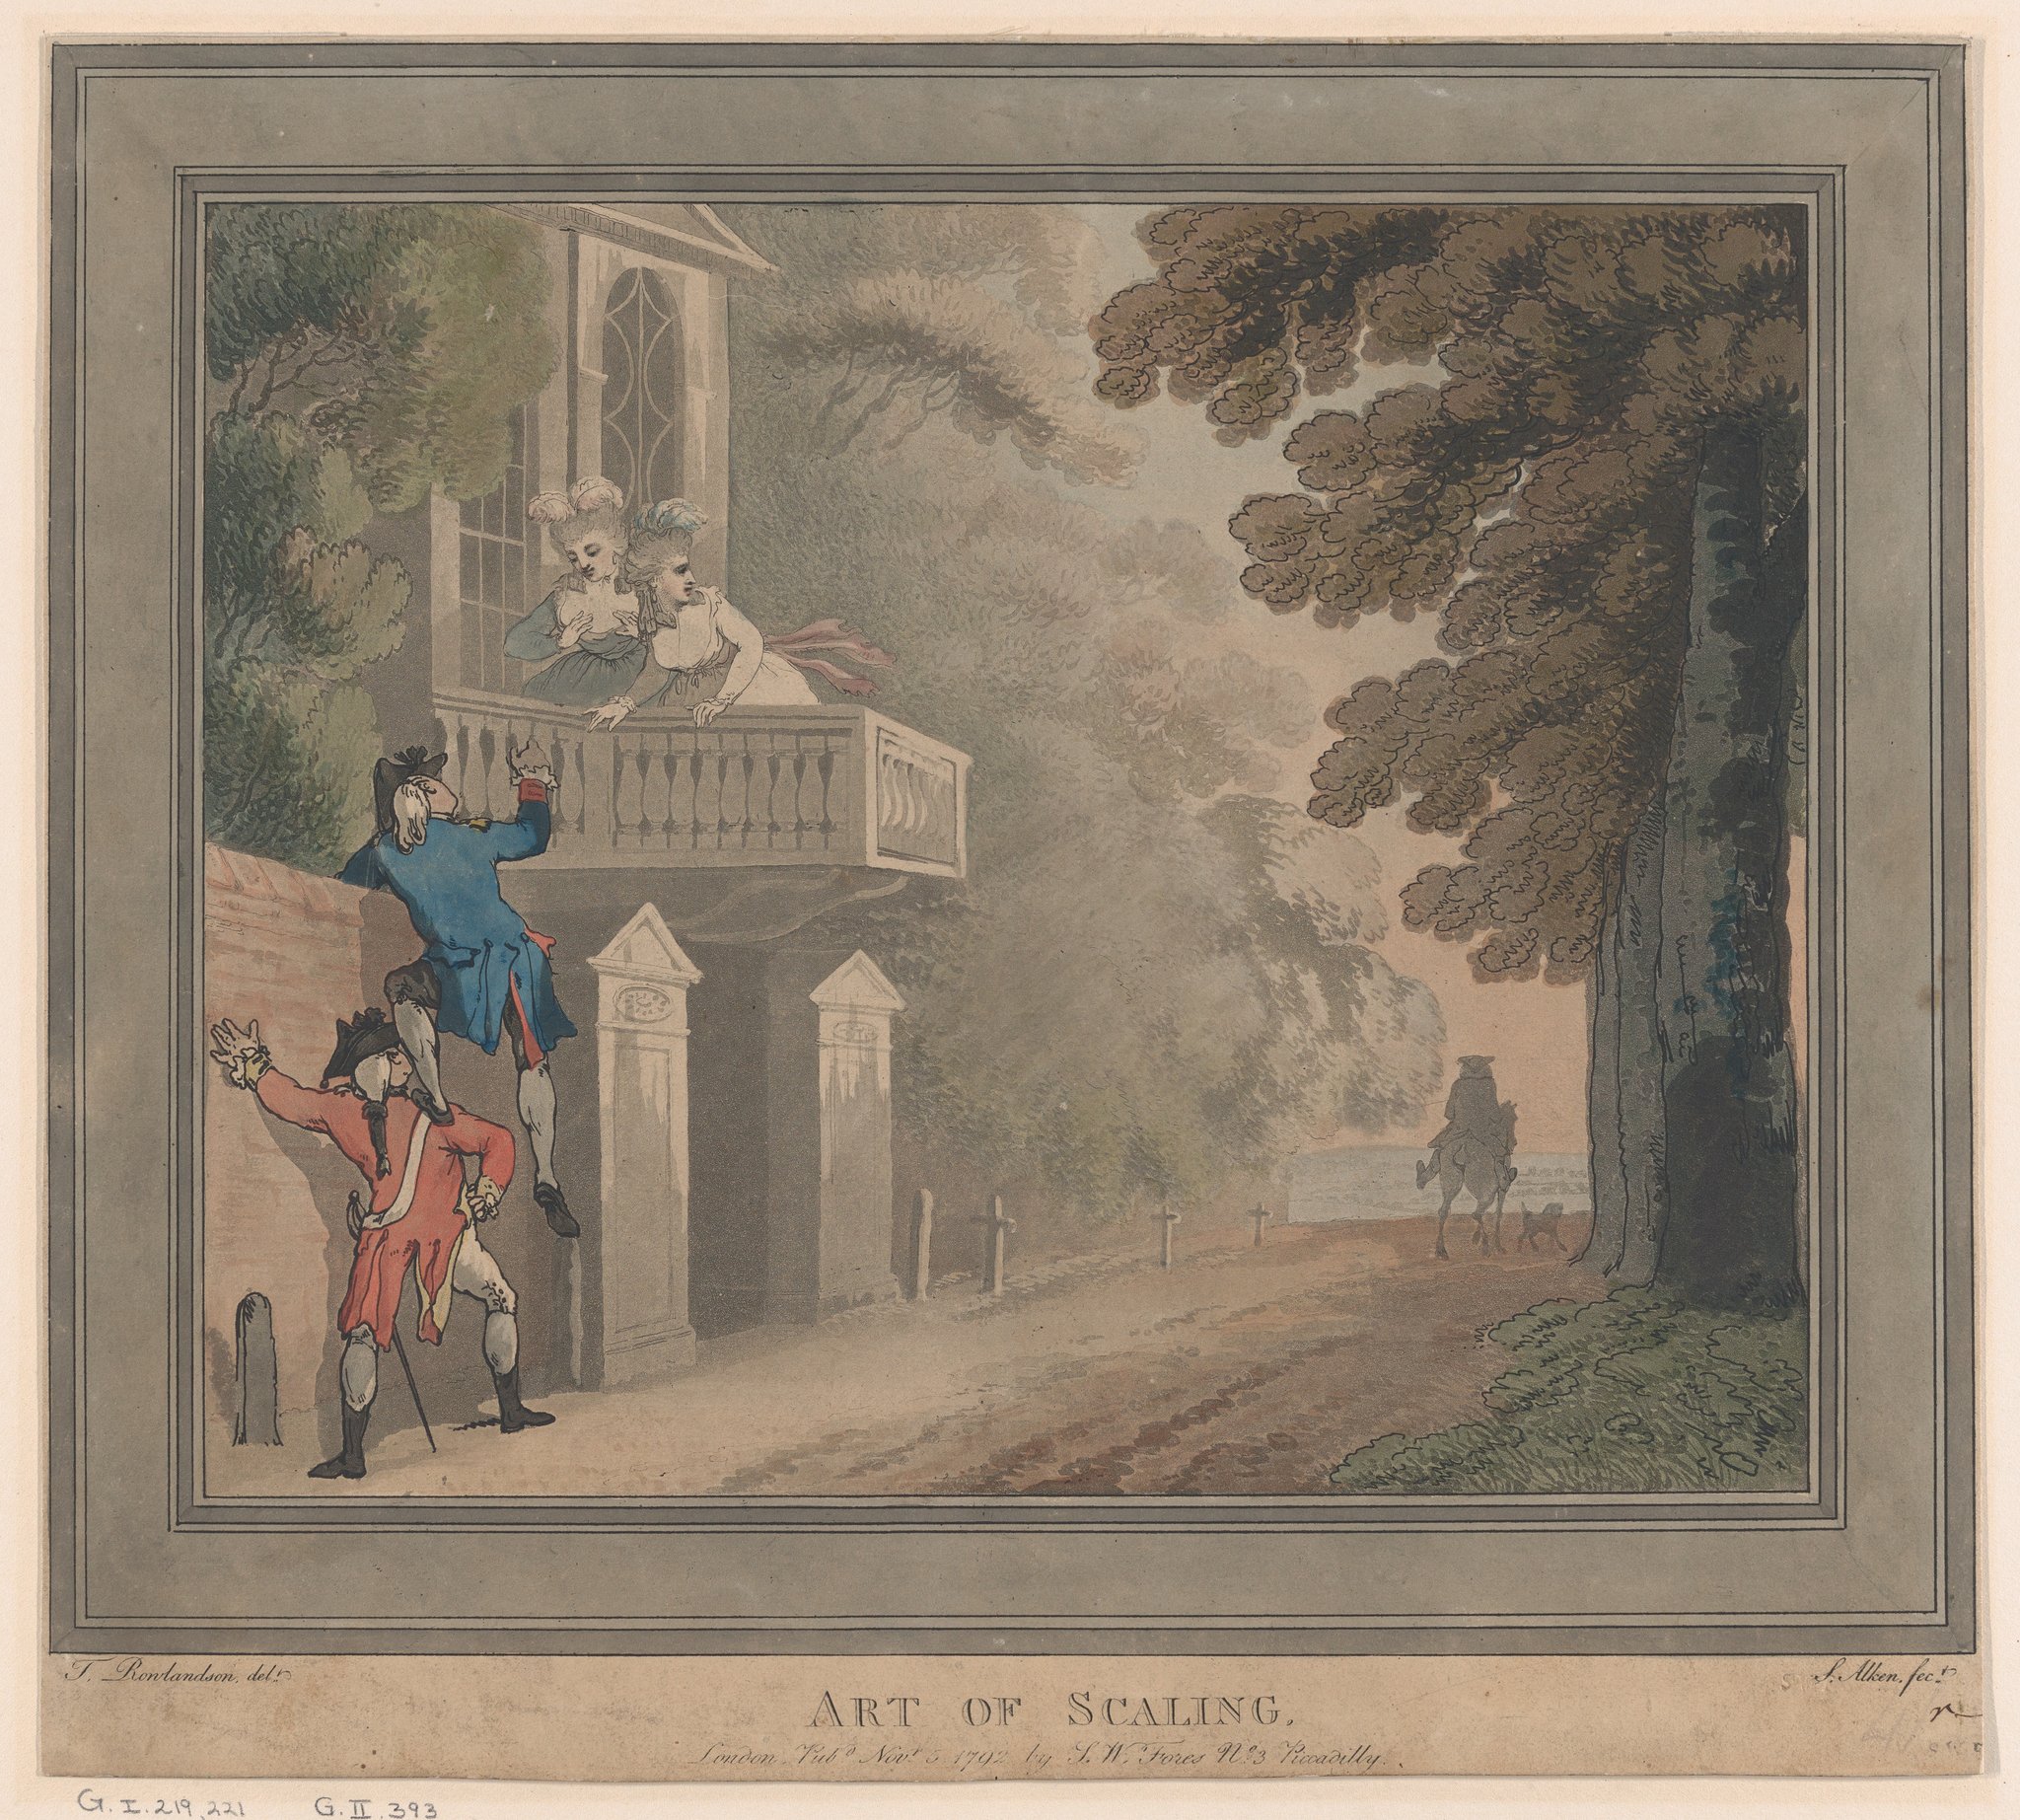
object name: print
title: Art of Scaling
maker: samuel alken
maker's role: etcher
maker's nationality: british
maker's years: 1756-1815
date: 1792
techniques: aquatint, etching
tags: balconies,men,women